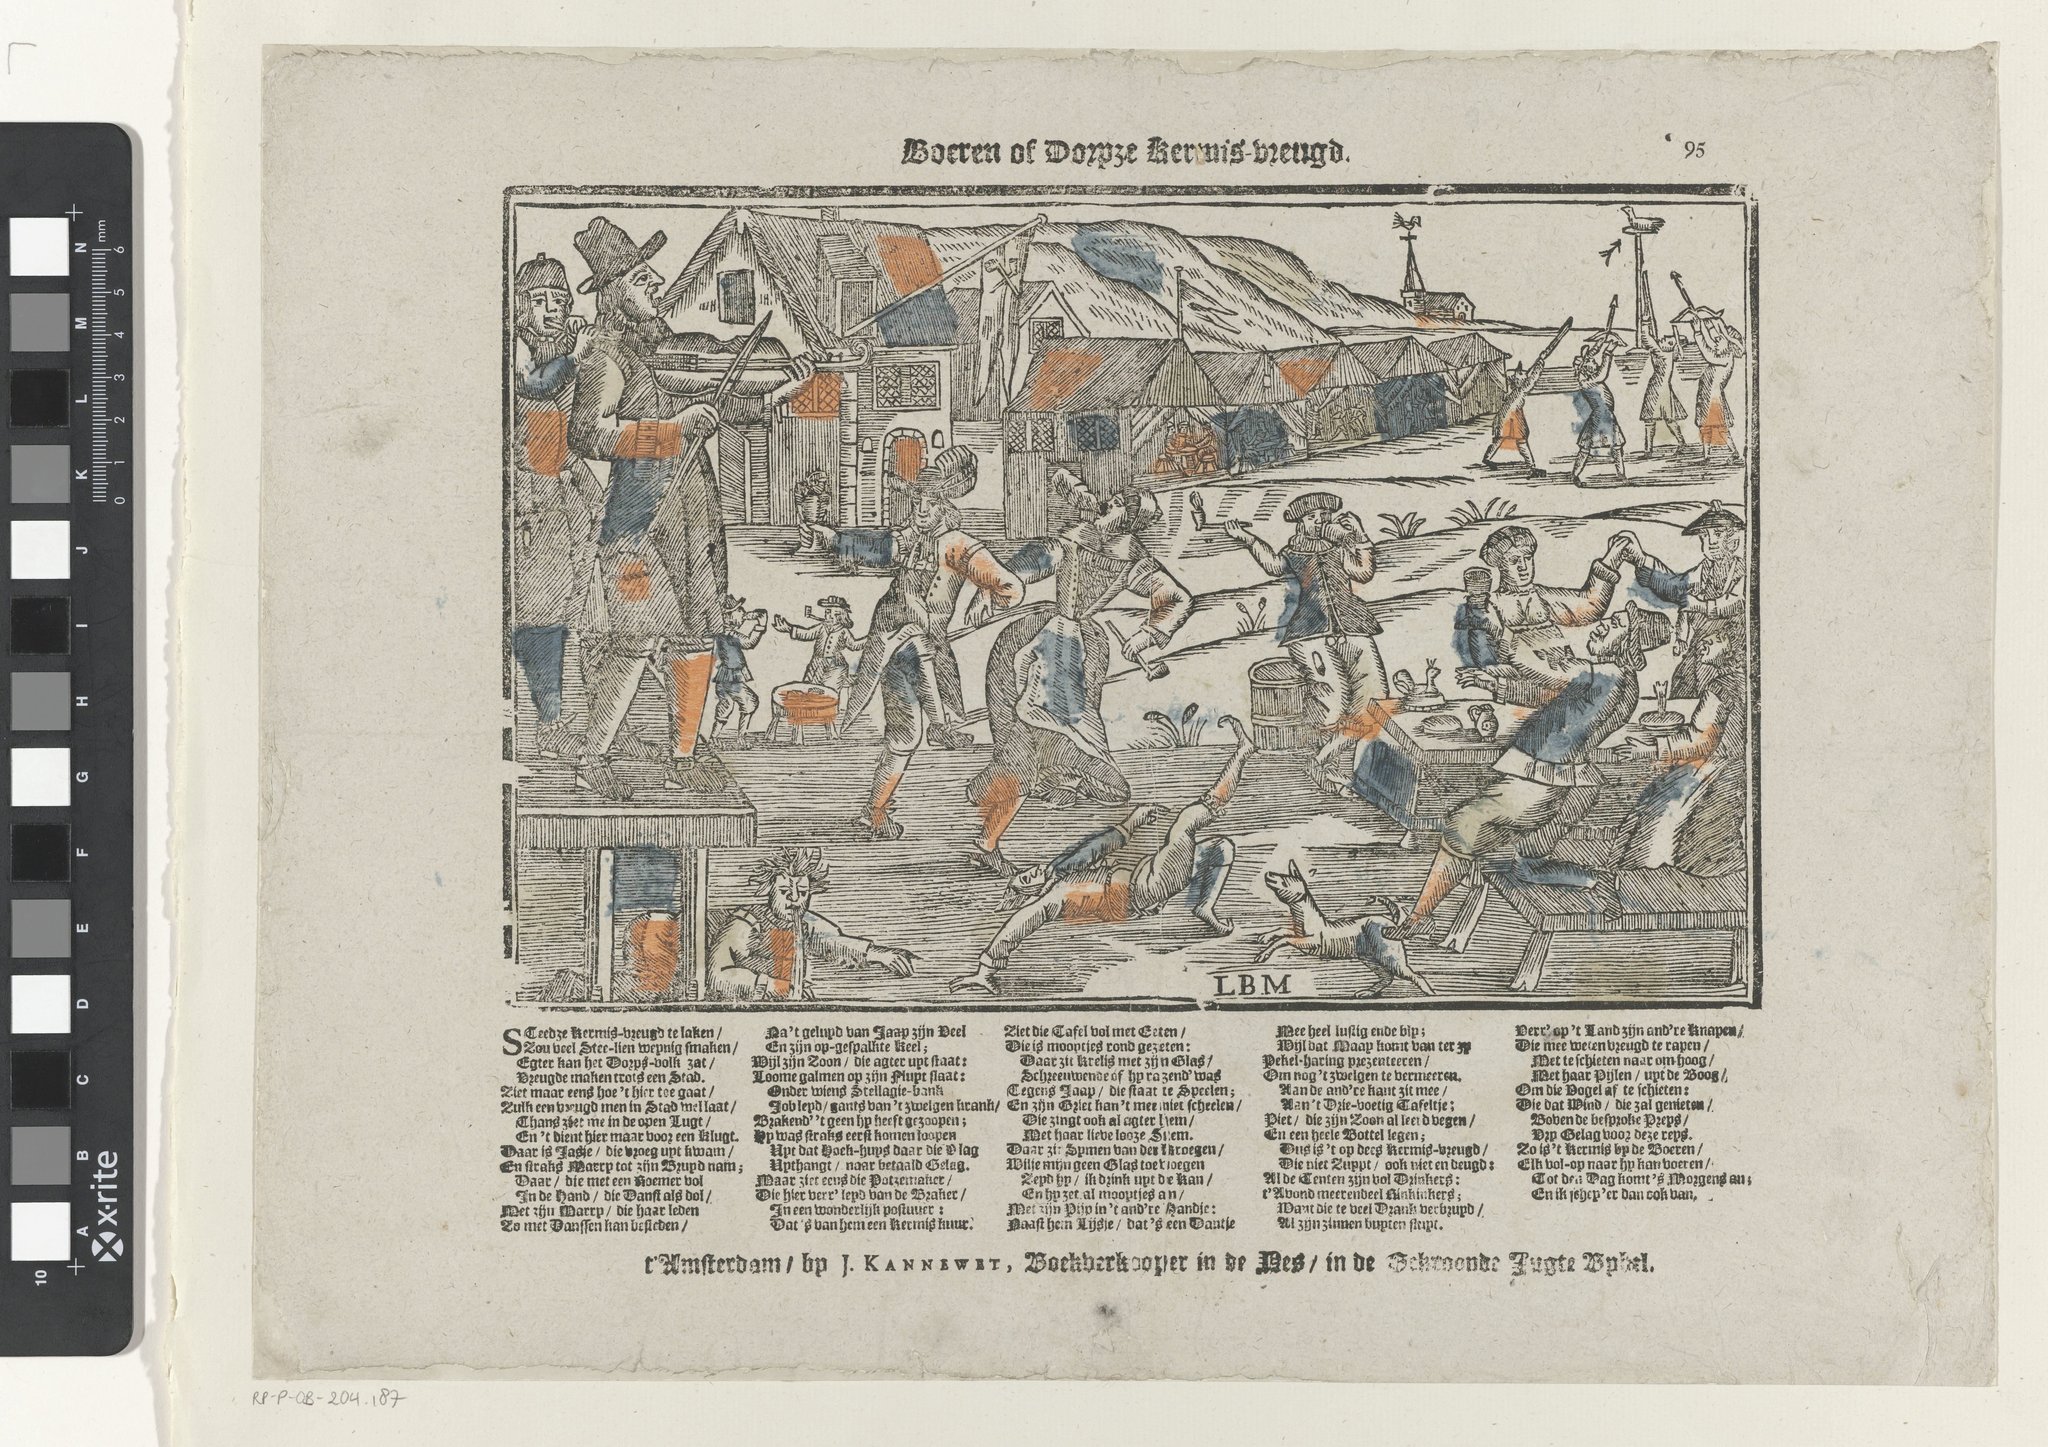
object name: popular print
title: Boeren of dorpze kermis-vreugd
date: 1725-1780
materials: paper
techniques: colour, letterpress printing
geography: amsterdam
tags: (annual) fair, trade fair, one pair dancing; man and woman dancing as a couple, pleasure fair and circus, instrumental popular music, shooting-the-bird (on a high pole)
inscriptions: collector's mark: Lugt 2760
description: Kermis in een boerendorp. Met boeren die eten en drinken en dansen op de muziek van de muzikanten links. Op de achtergrond kraampjes en schieten op de papegaai. Onder de voorstelling een vers in vijf kolommen. Genummerd rechtsboven: *95.